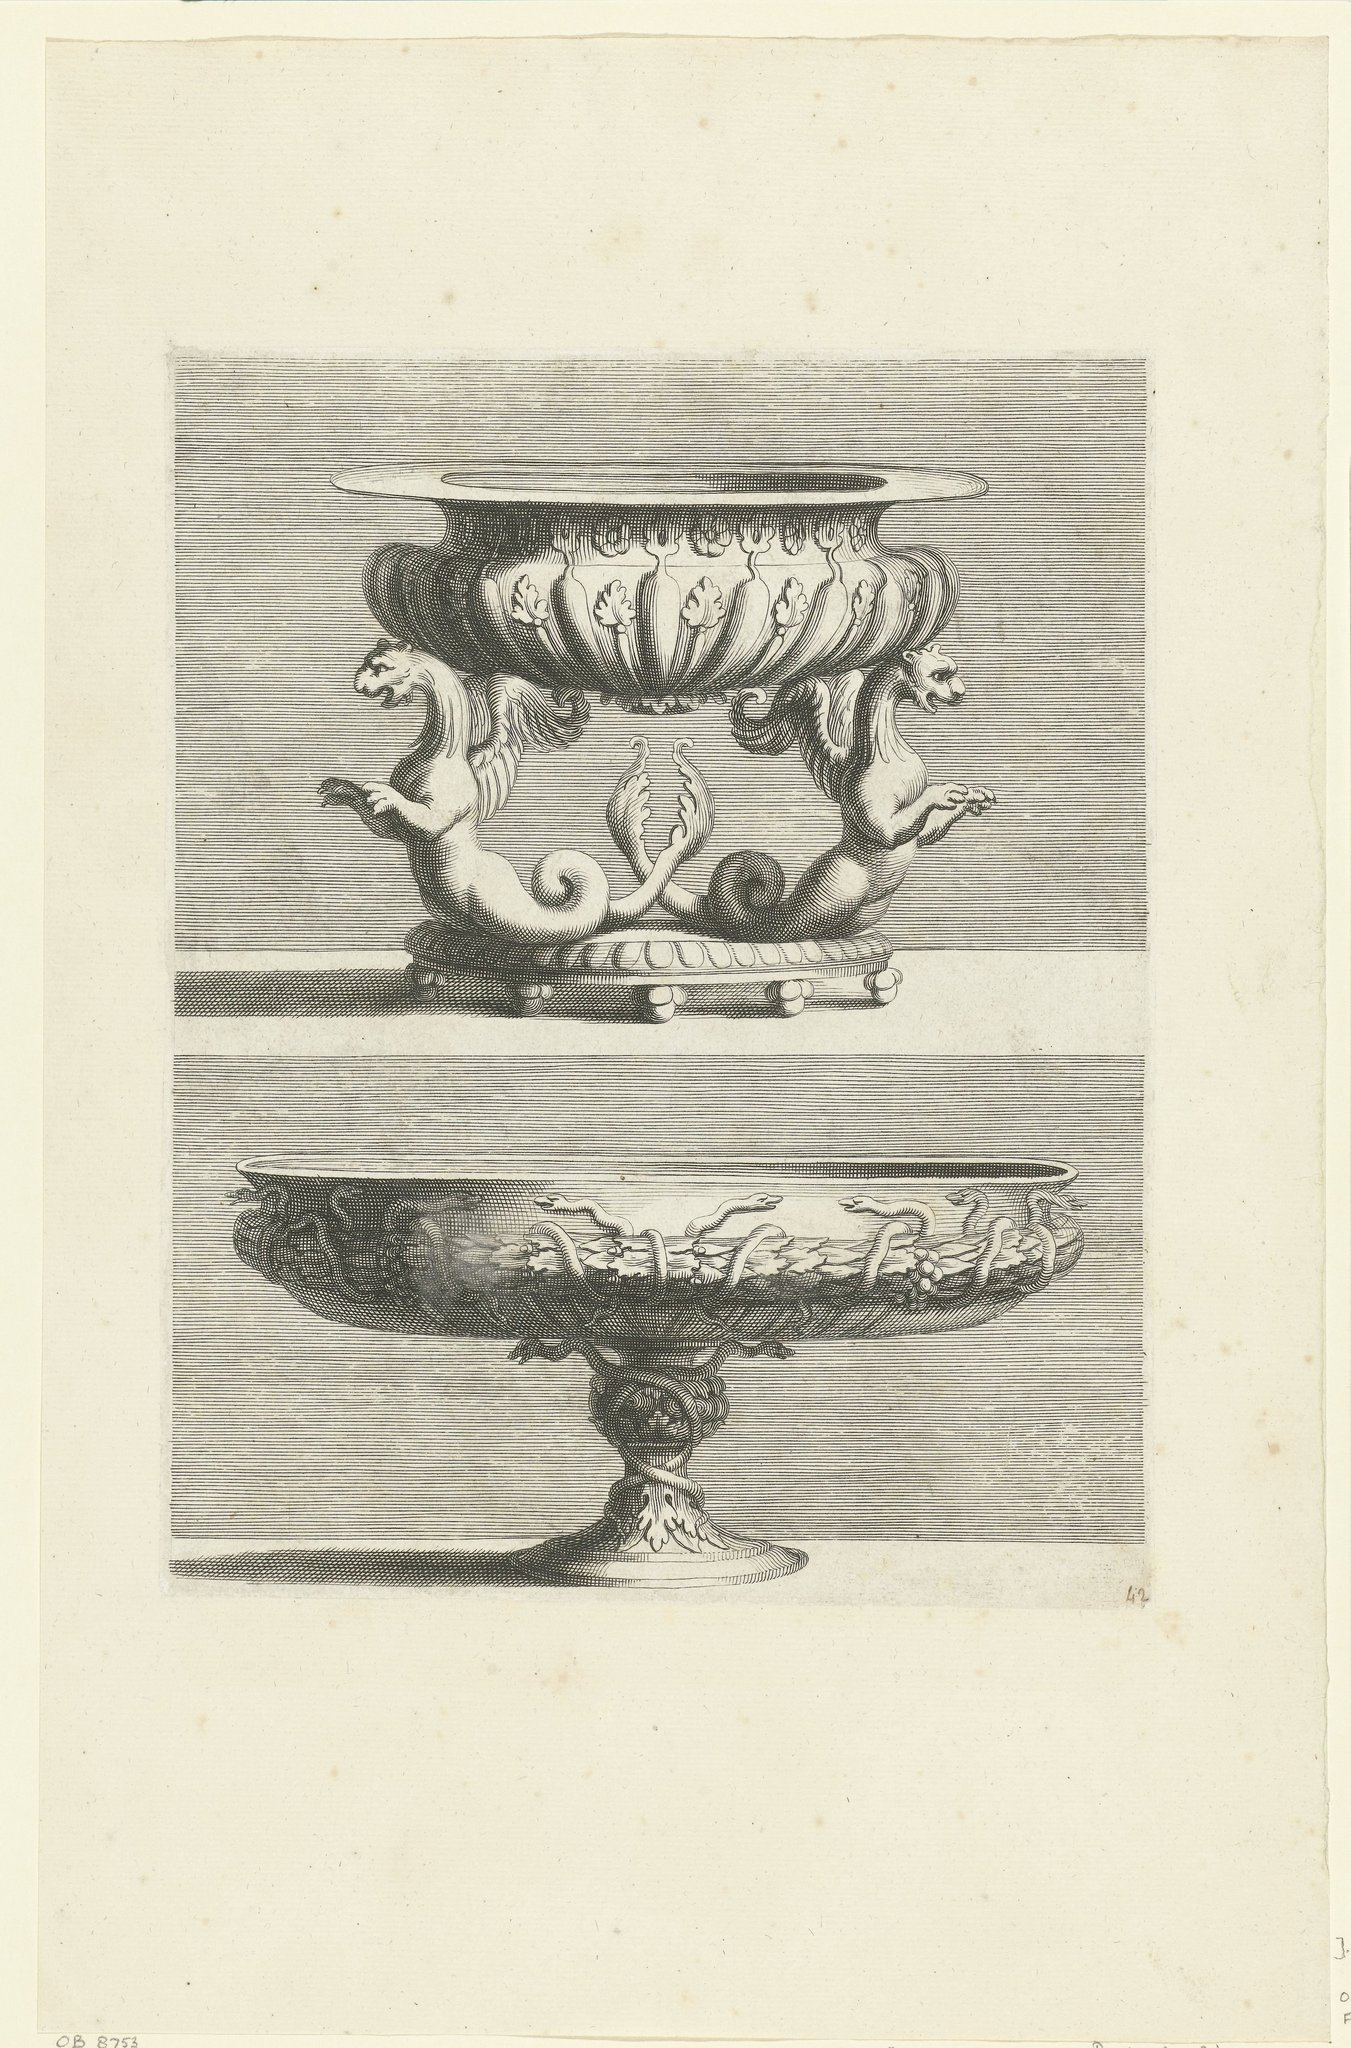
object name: ornament print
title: Second Livre de Vases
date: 1667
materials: paper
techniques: engraving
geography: paris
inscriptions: number: ‘42’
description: De bovenste schaal steunt op twee fantasiedieren met vleugels en leeuwenkoppen. Blad 42 uit serie van 25 bladen, genummerd: II (voorheen 26), 27-50.